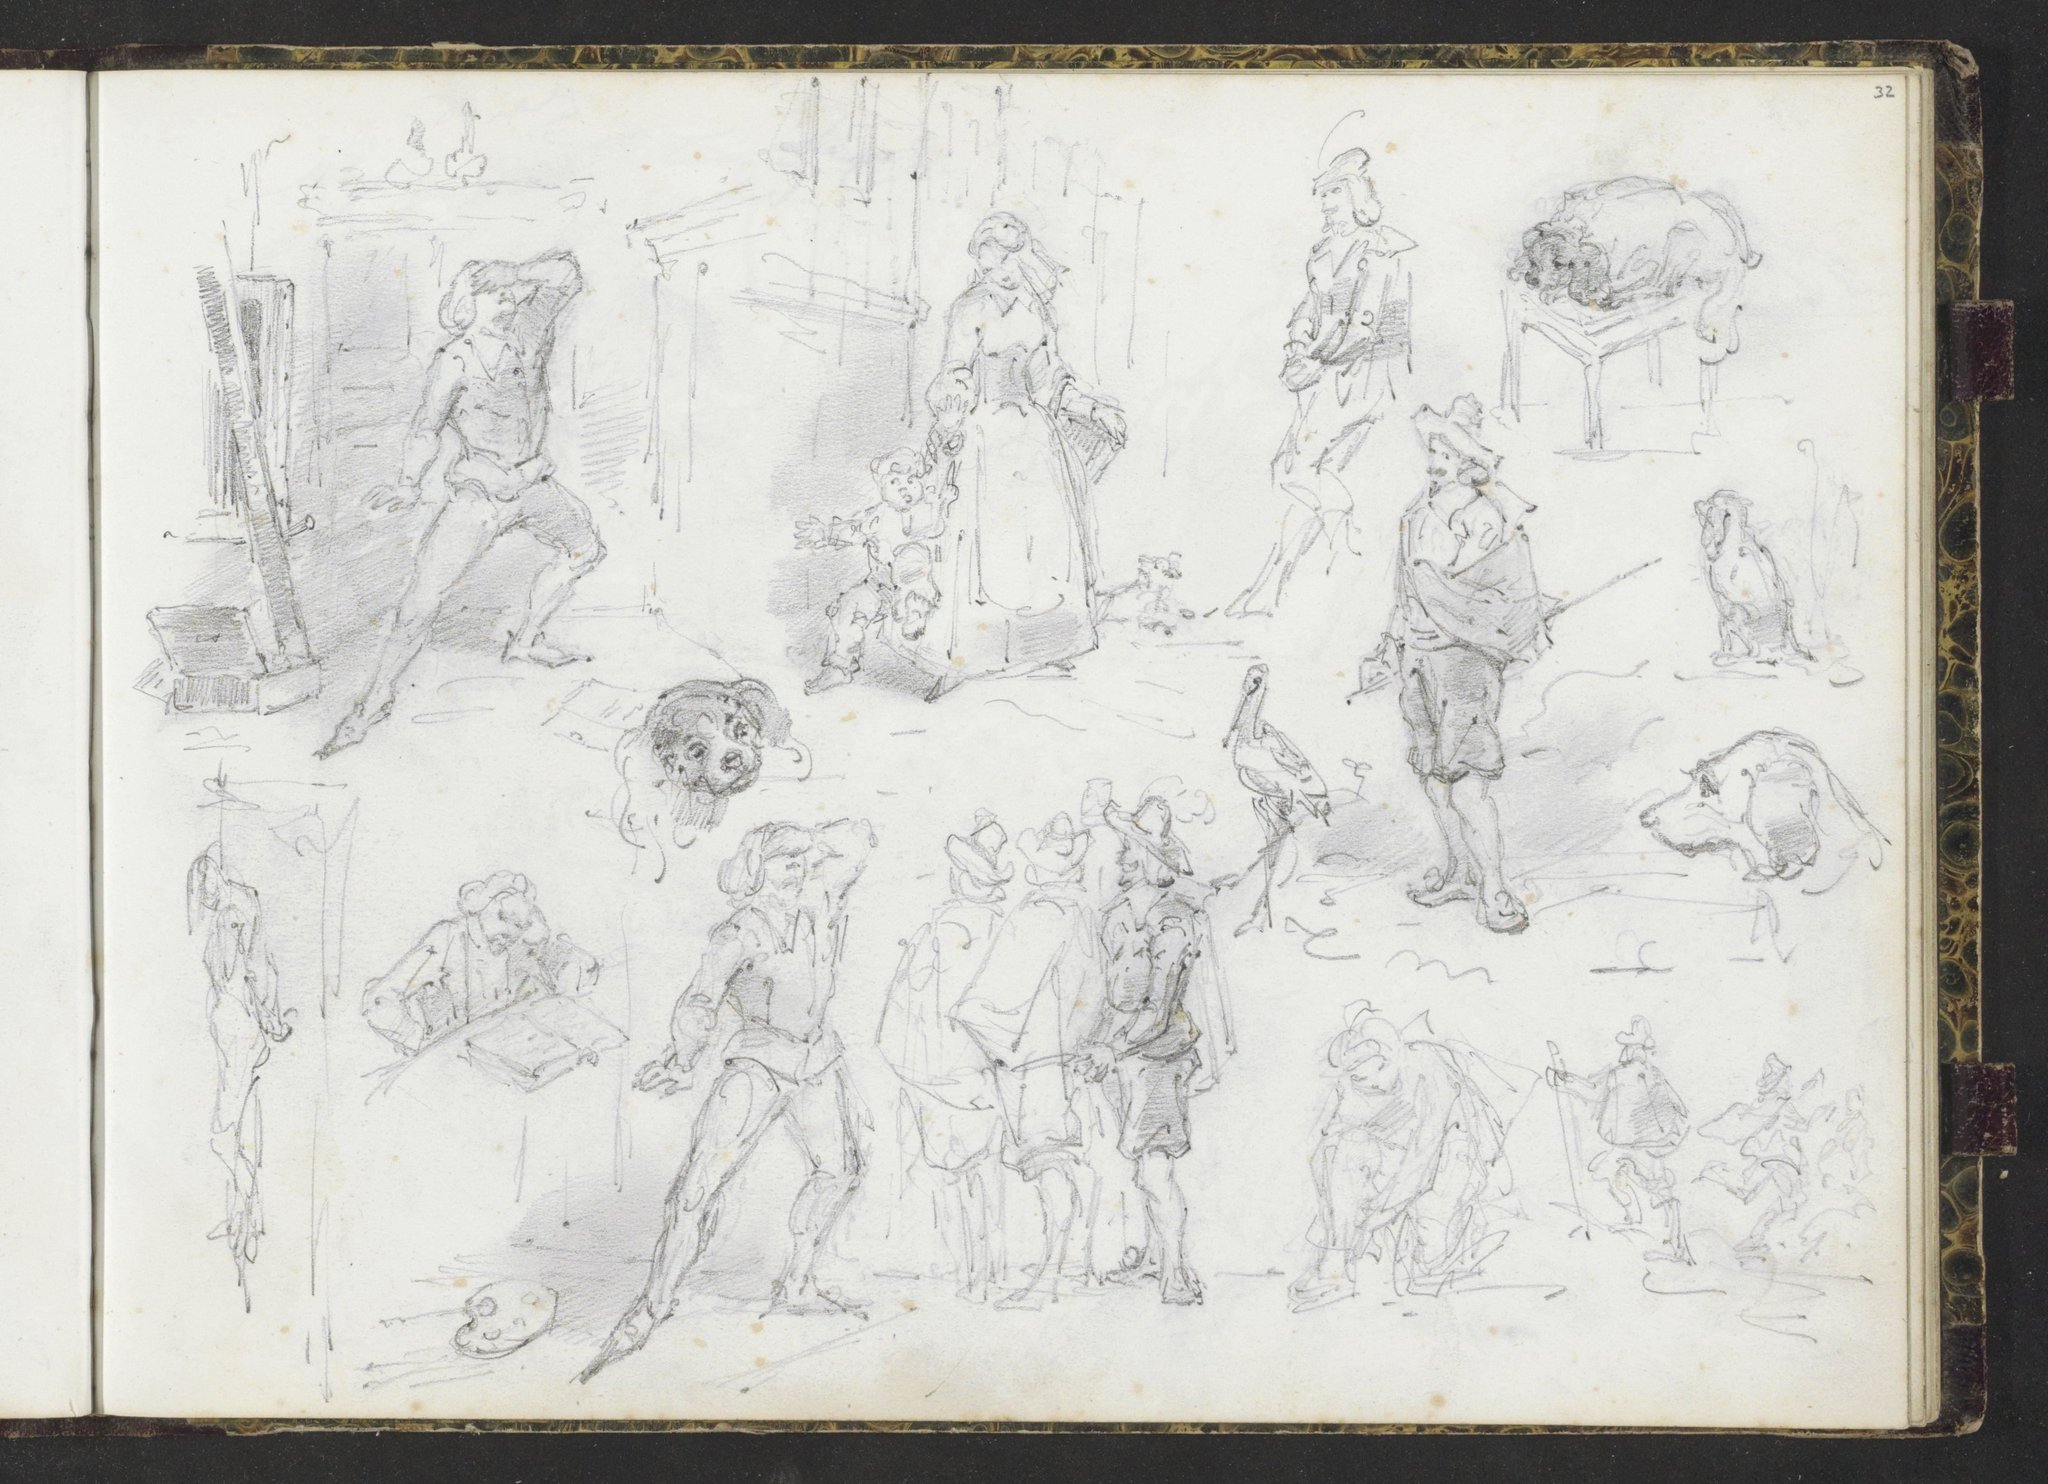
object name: sketchbook leaf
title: Studieblad met figuren in historisch kostuum, honden en een lezende man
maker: lambertus lingeman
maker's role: draughtsman, painter, print maker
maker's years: 1829-1894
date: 1839-1894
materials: paper, pencil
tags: reading, historical costume, dog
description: Tevens studies van een ooievaar en een moeder met kind op een straat. Blad 32 recto uit een schetsboek met 51 bladen.